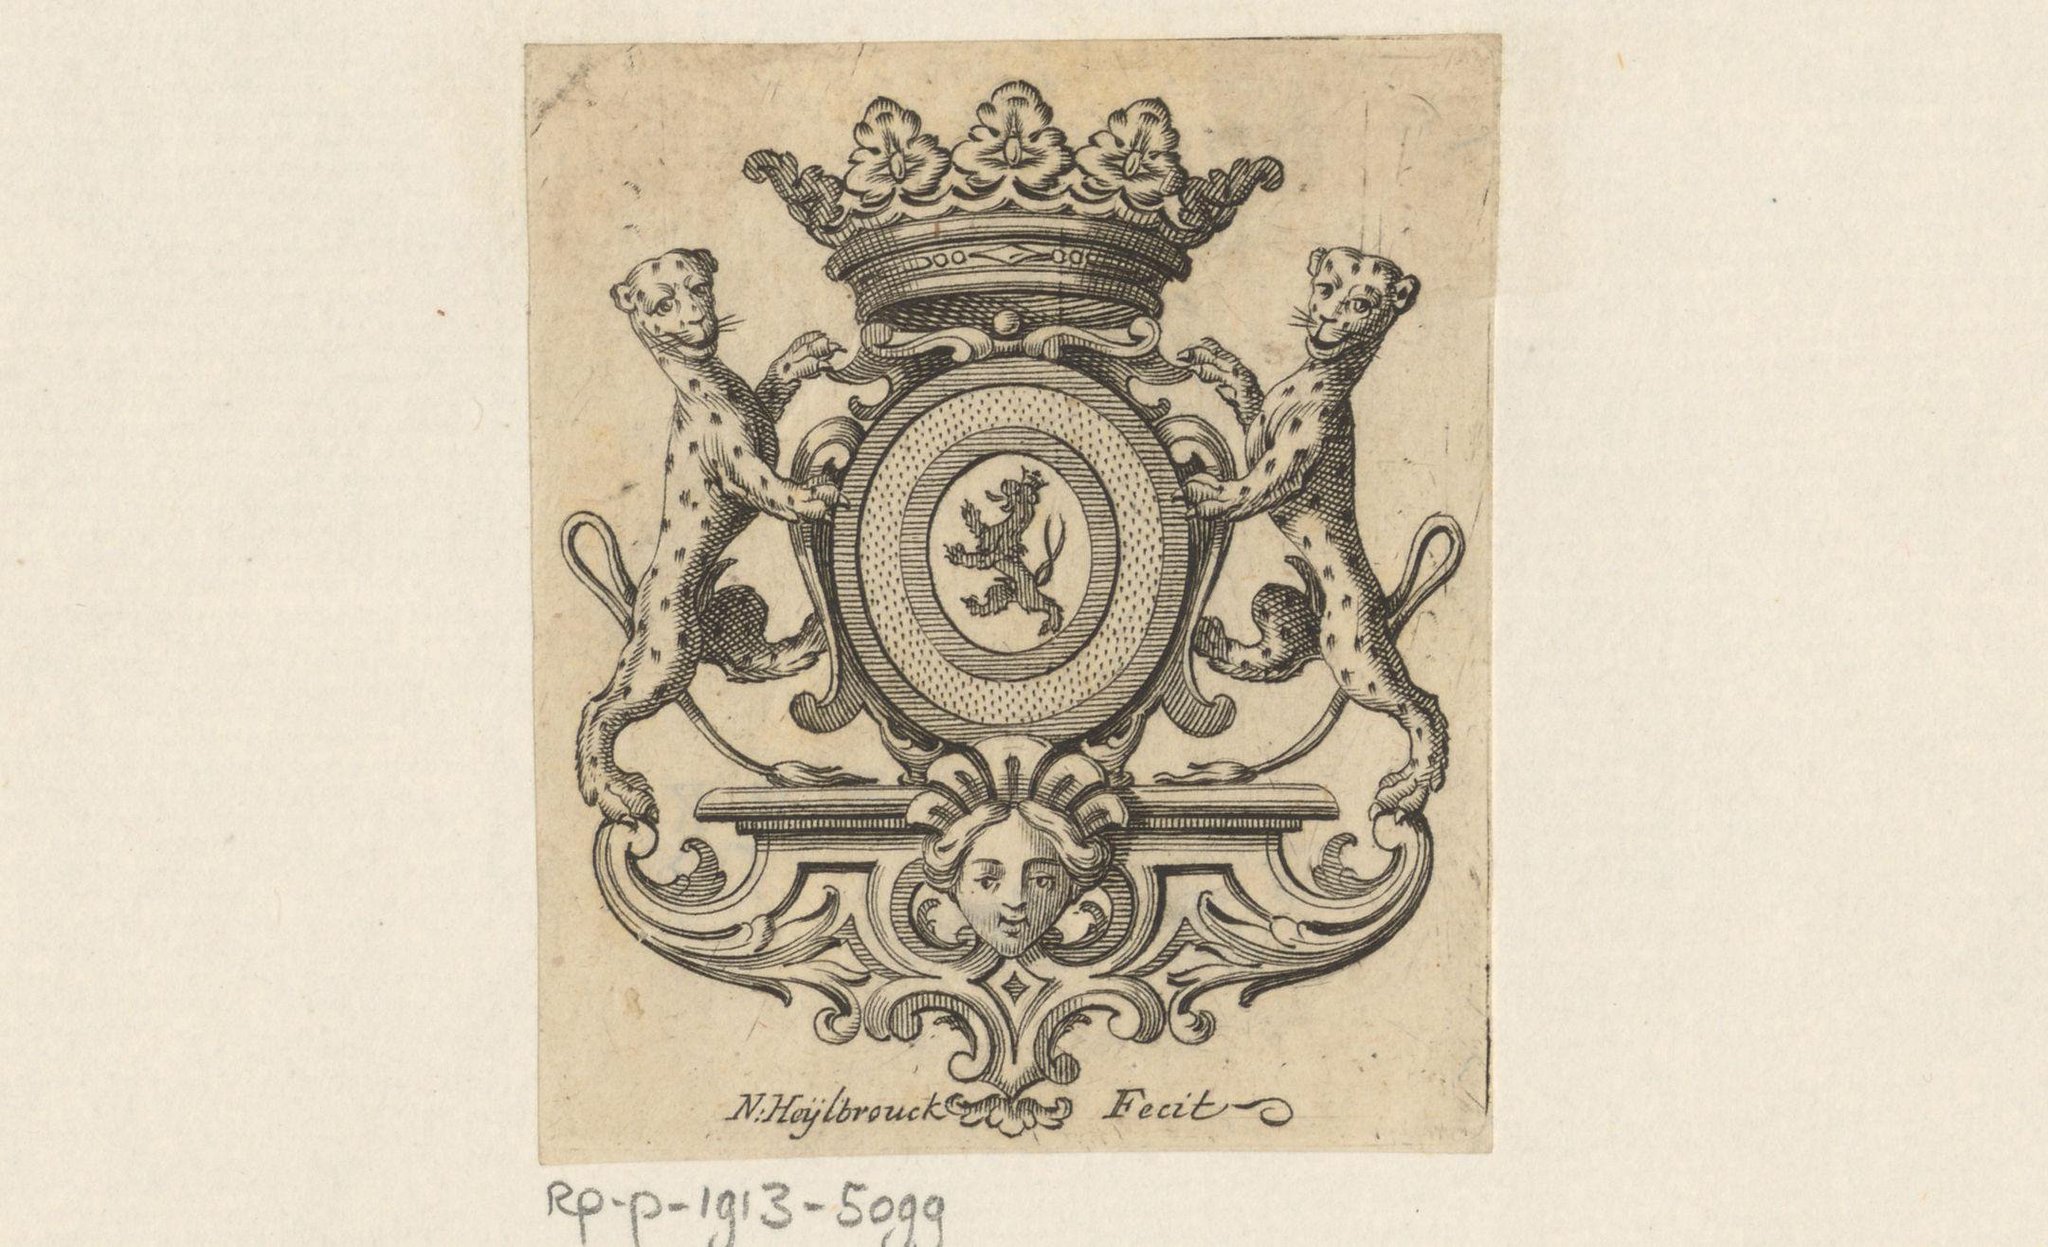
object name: bookplate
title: Ex libris van onbekend, mogelijk De Thiennes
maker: norbert heylbrouck (i)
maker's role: print maker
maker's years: 1675-1762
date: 1700-1799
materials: paper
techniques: engraving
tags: armorial bearing, heraldry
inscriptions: collector's mark: Lugt 2760, collector's mark: Lugt 2233